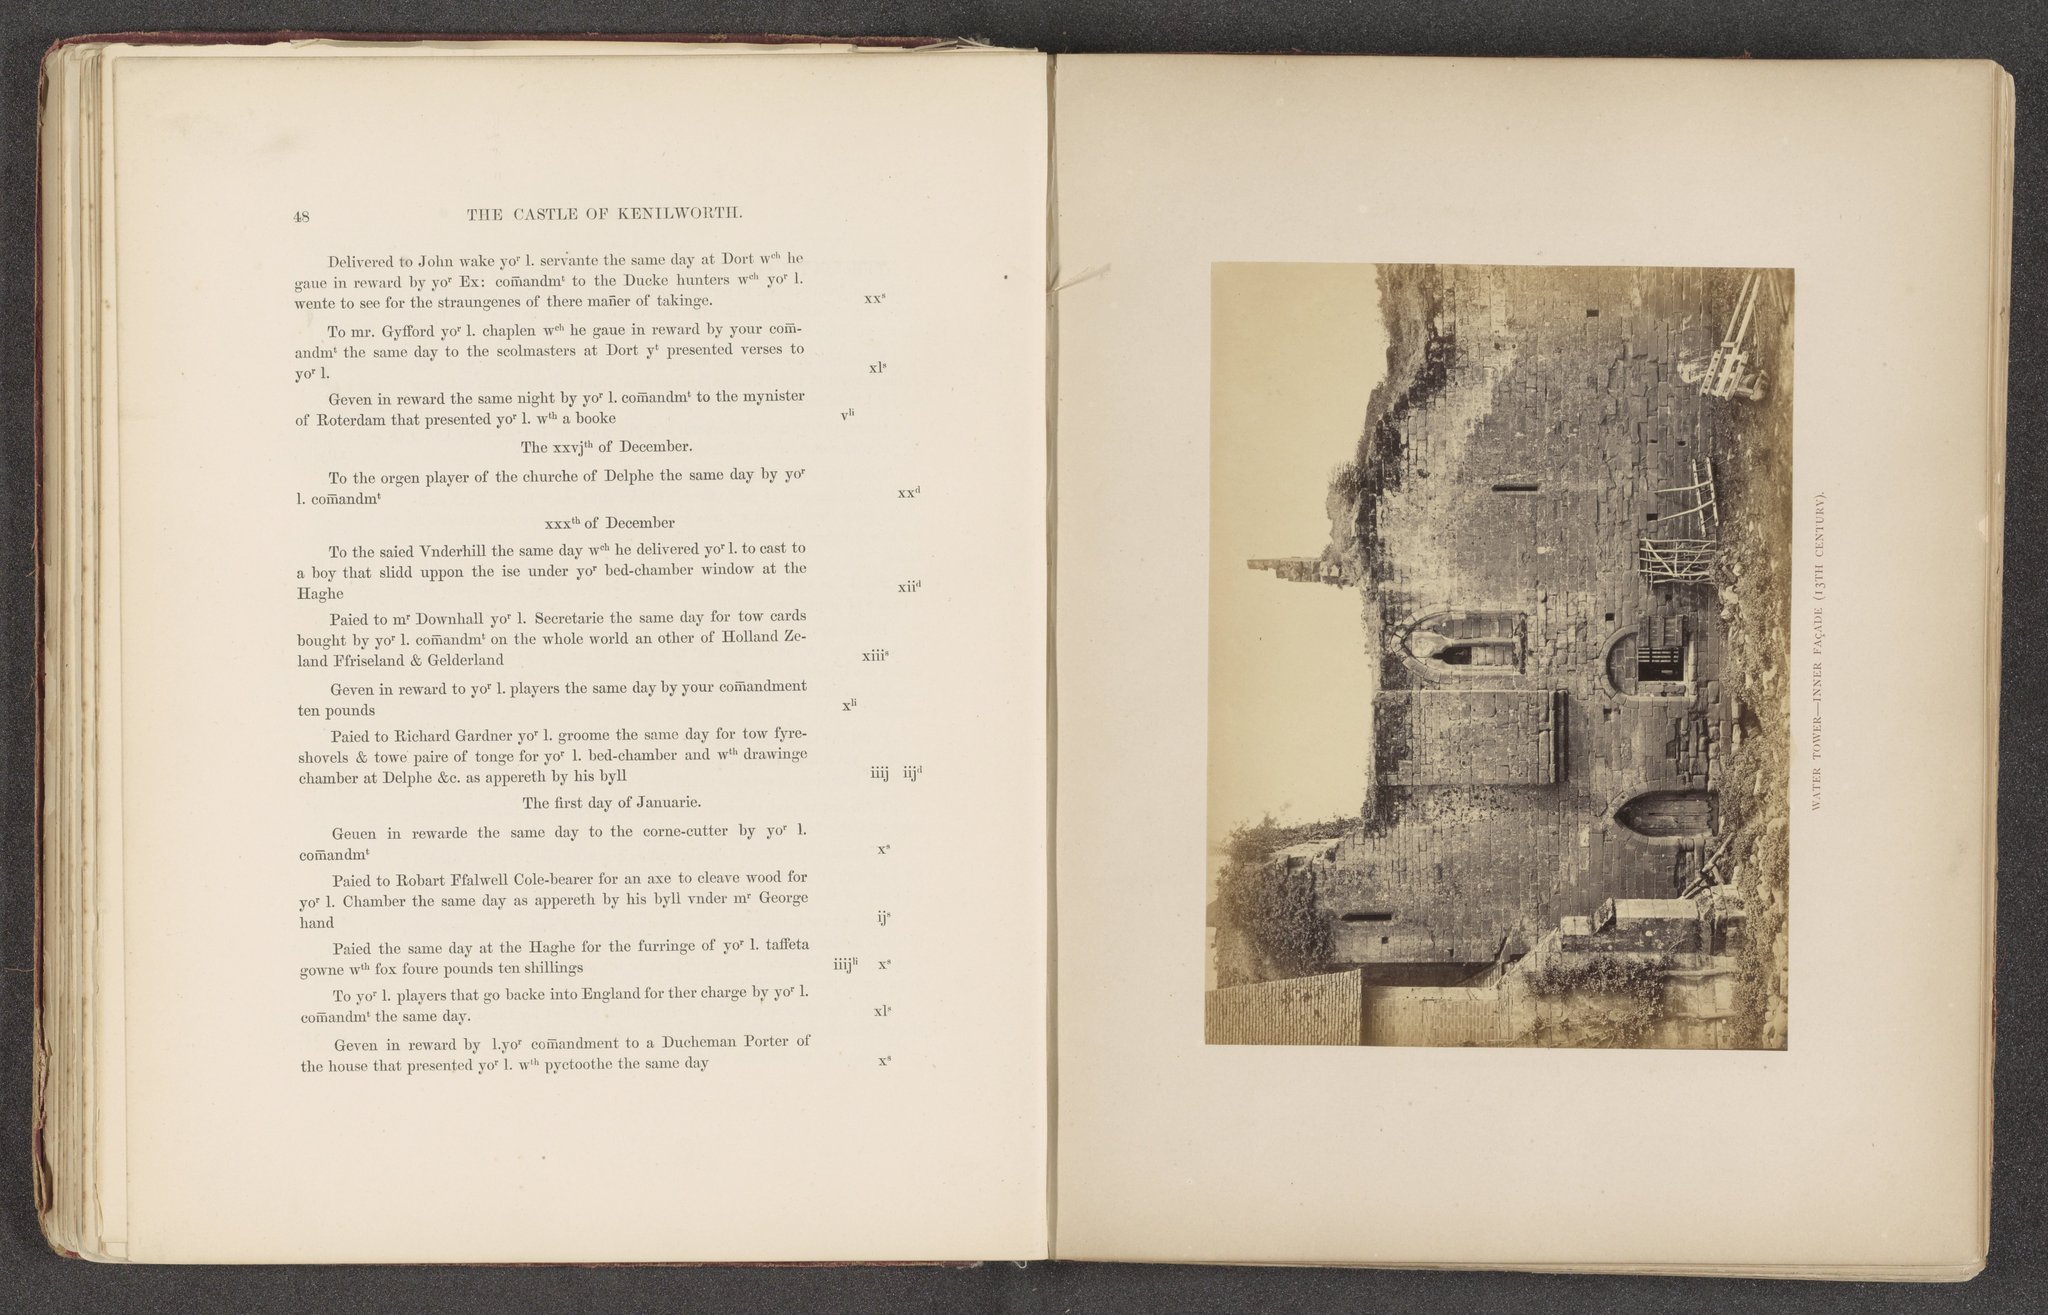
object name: photograph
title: Water Touwer-Inner façade (13th Century)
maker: Anonymous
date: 1862-1872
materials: photographic support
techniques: albumen print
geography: kenilworth castle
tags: water tower, ruin of a dwelling, house, castle, etc.